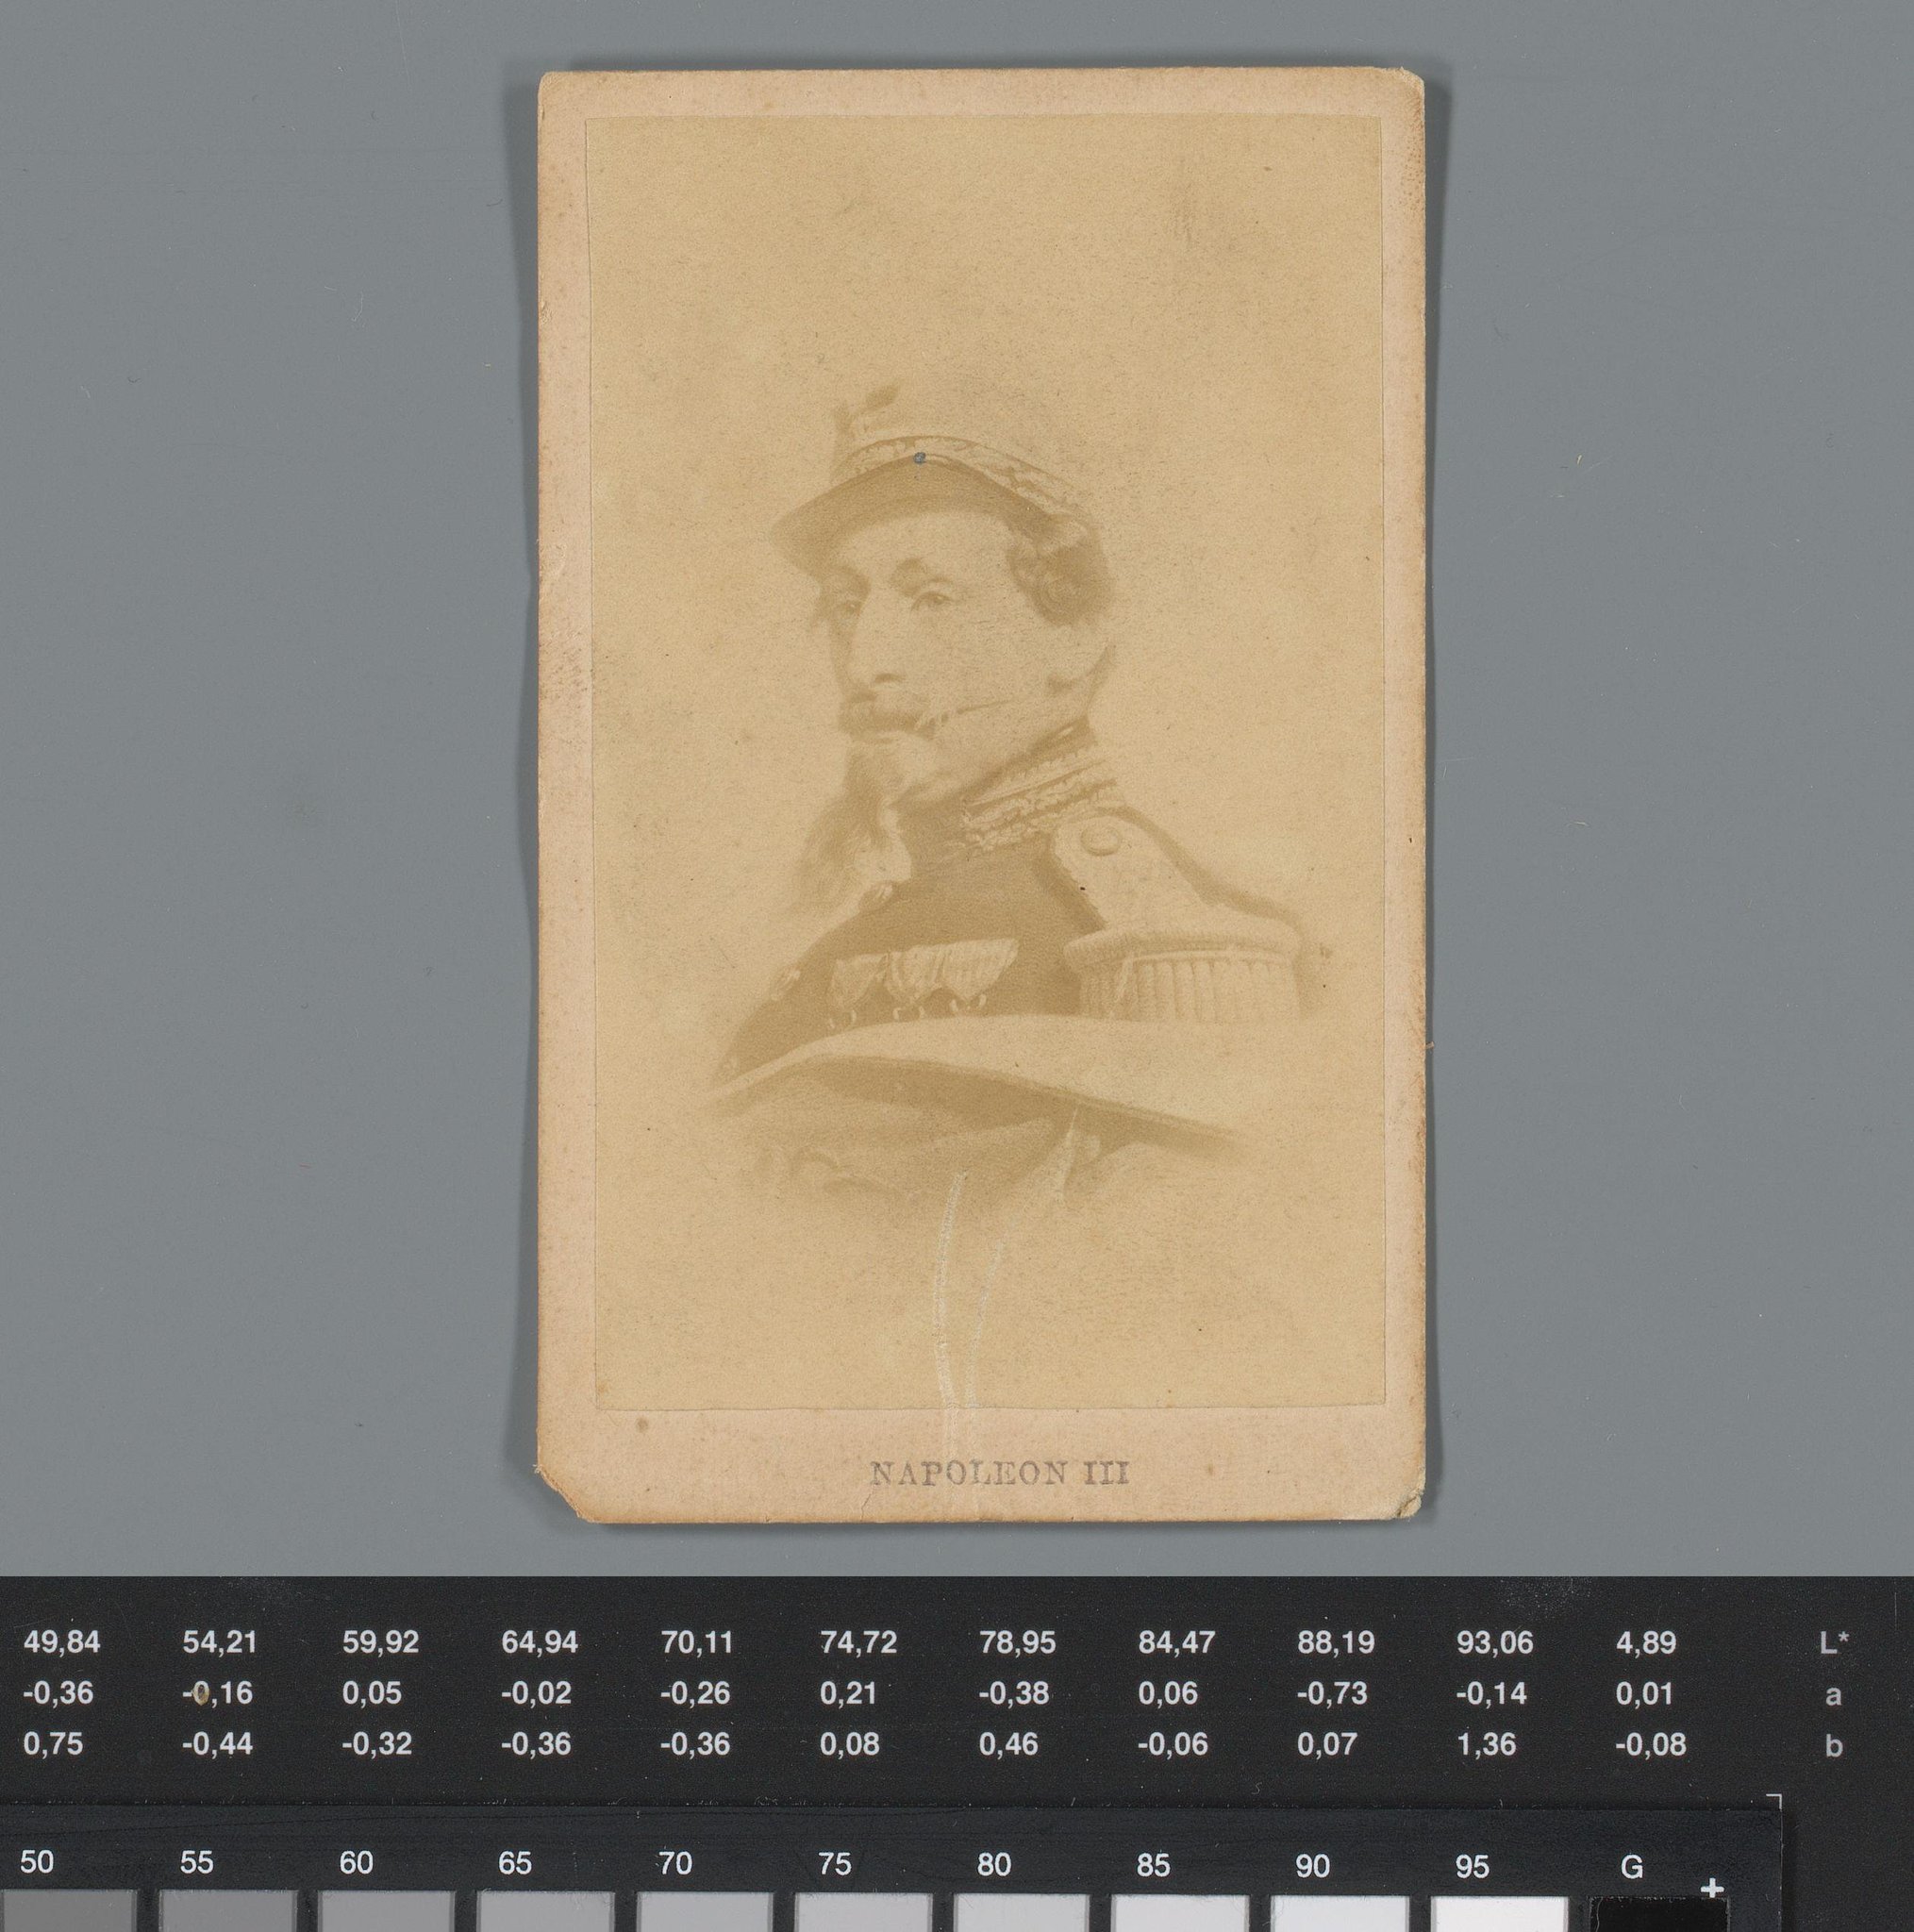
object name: carte de visite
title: Reclame voor kledingstomerij en -reparatie met portret van Napoleon III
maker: Anonymous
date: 1850-1915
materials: cardboard, photographic support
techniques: albumen print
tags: paris, london, napoleon iii (keizer der fransen), advertising, historical persons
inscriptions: inscription: ‘ECONOMY / Instead of buying your new Clothing / get your / old clothing / Cleaned, Dyed and Repaired (...) PHILADELPHIA / Steam Dyeing & Cleaning Establishment (...)’